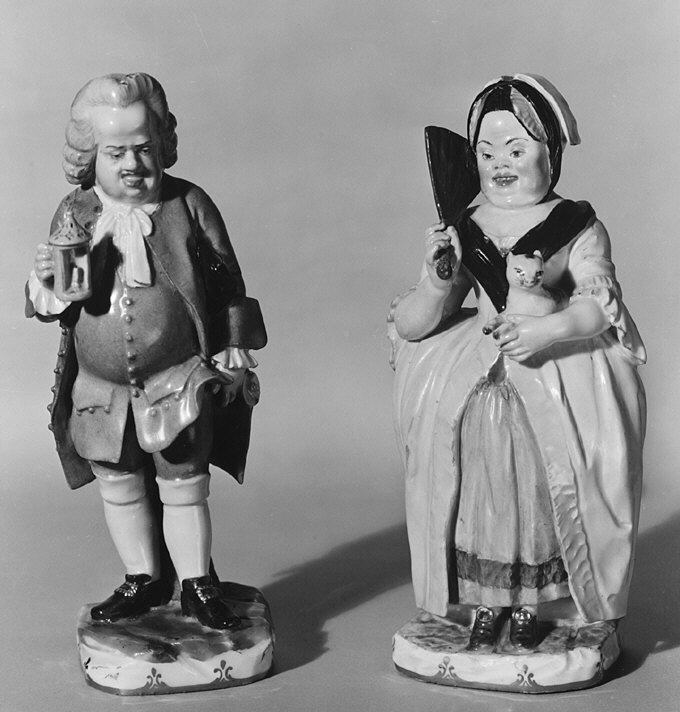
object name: figure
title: Burgomaster's Wife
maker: imperial porcelain manufactory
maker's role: manufactory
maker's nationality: austrian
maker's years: 1744-1864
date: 1765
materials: hard paste porcelain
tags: men,women